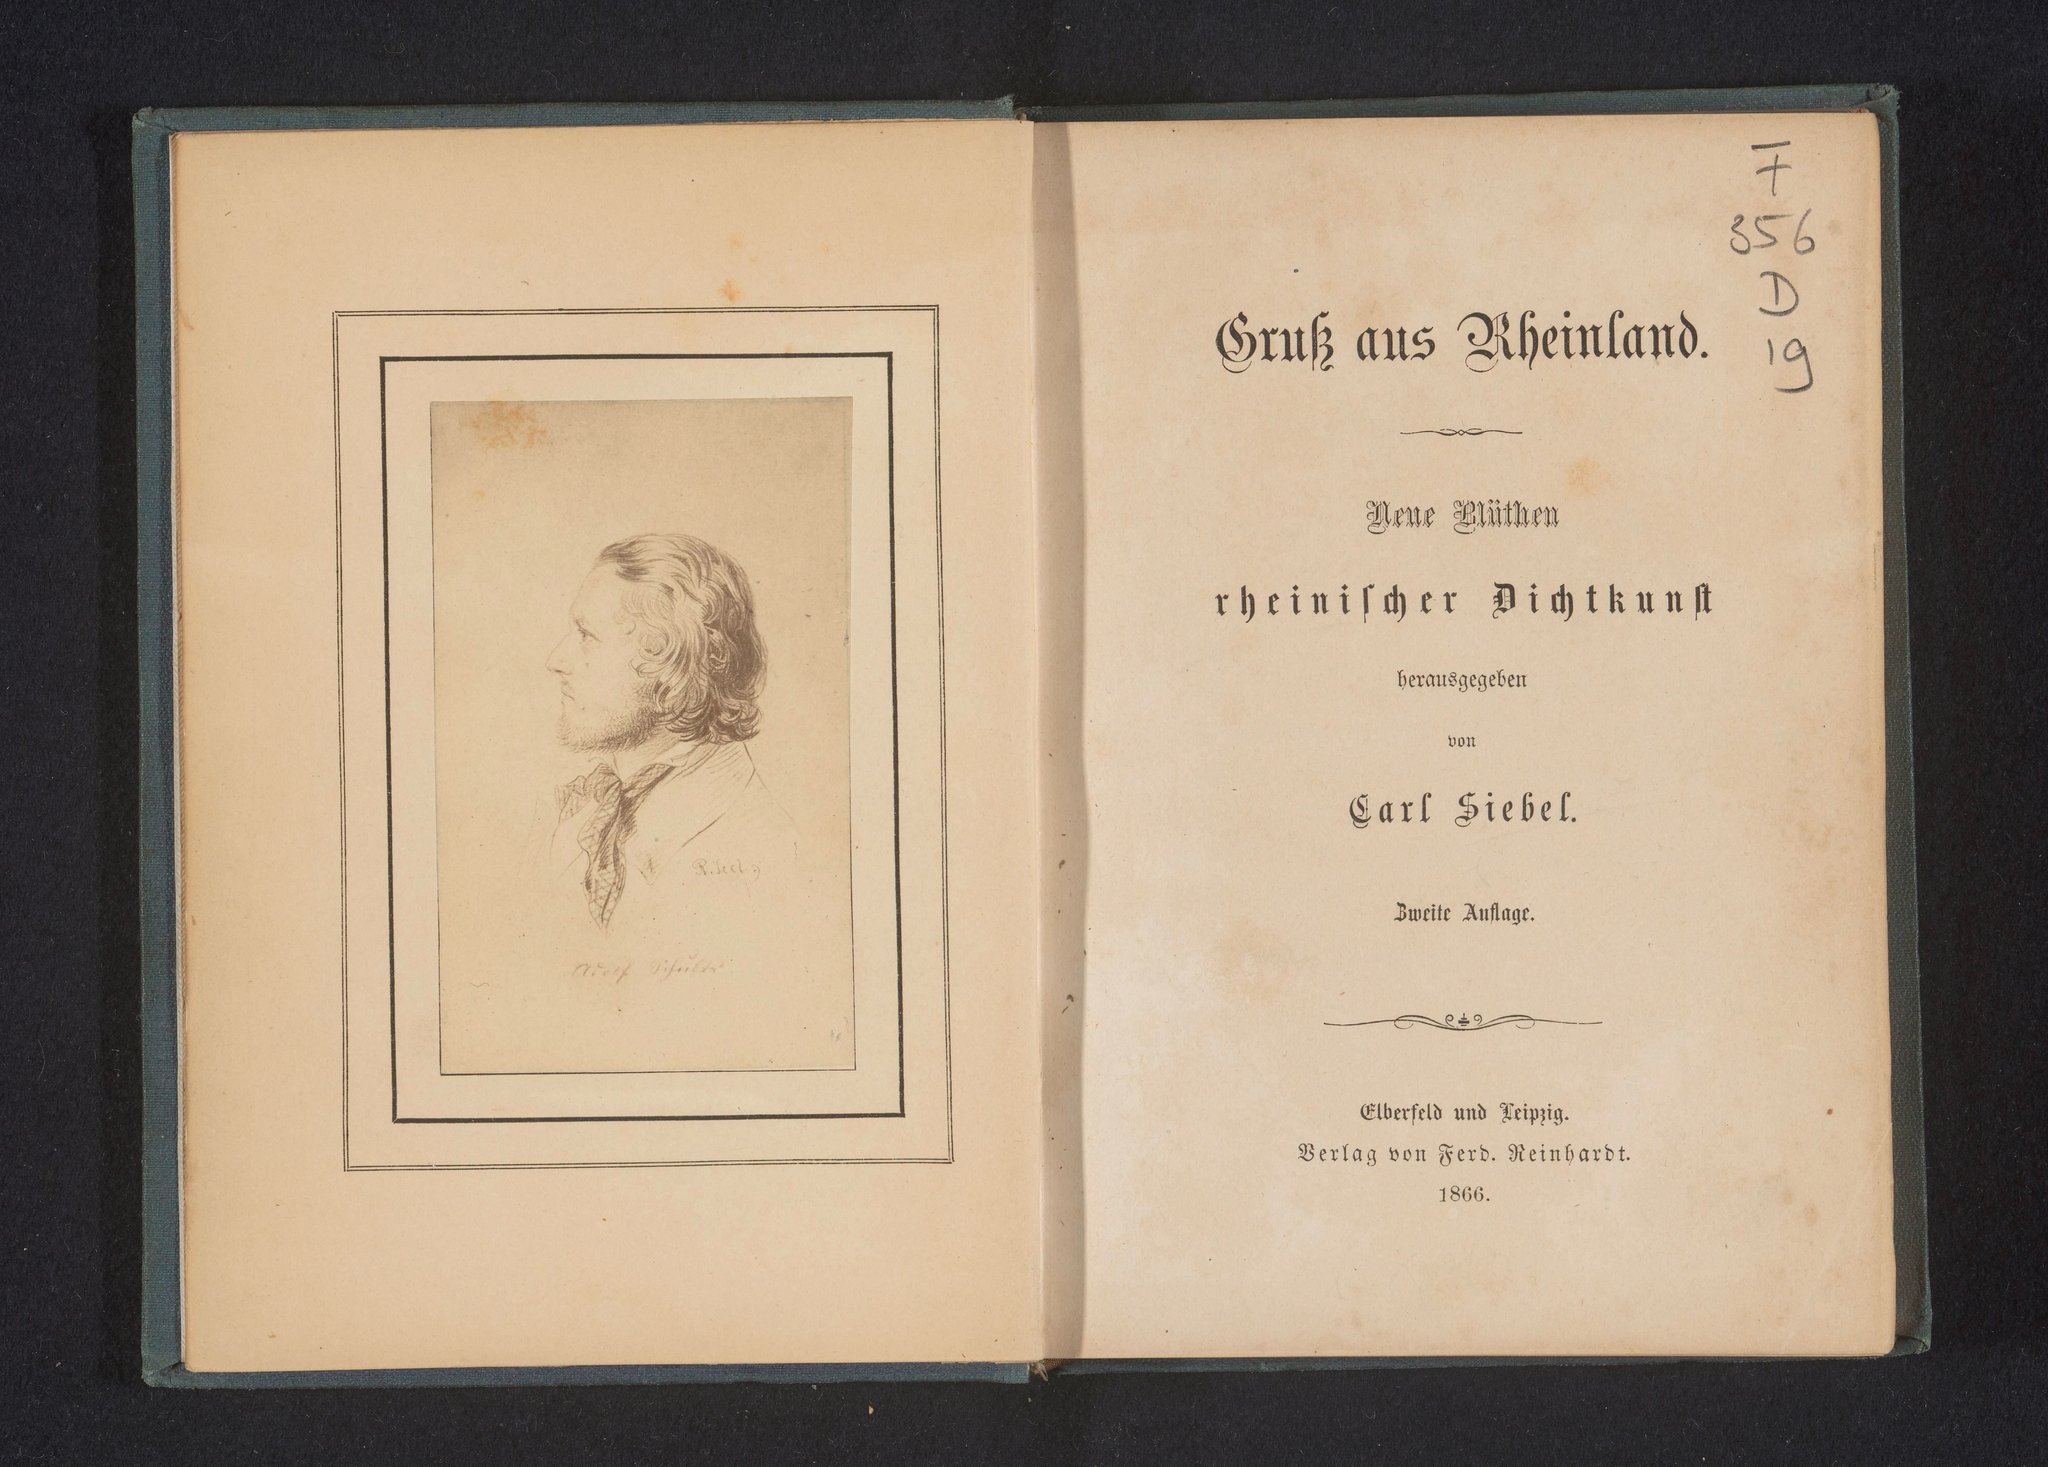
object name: book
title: Gruss aus Rheinland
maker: carl siebel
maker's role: dichter, koopman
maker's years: 1836-1868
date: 1866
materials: cardboard, linen, paper, photographic support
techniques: albumen print, printing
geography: elberfeld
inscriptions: inscription: ‘Bergische Sammlung Ernst Bertram’